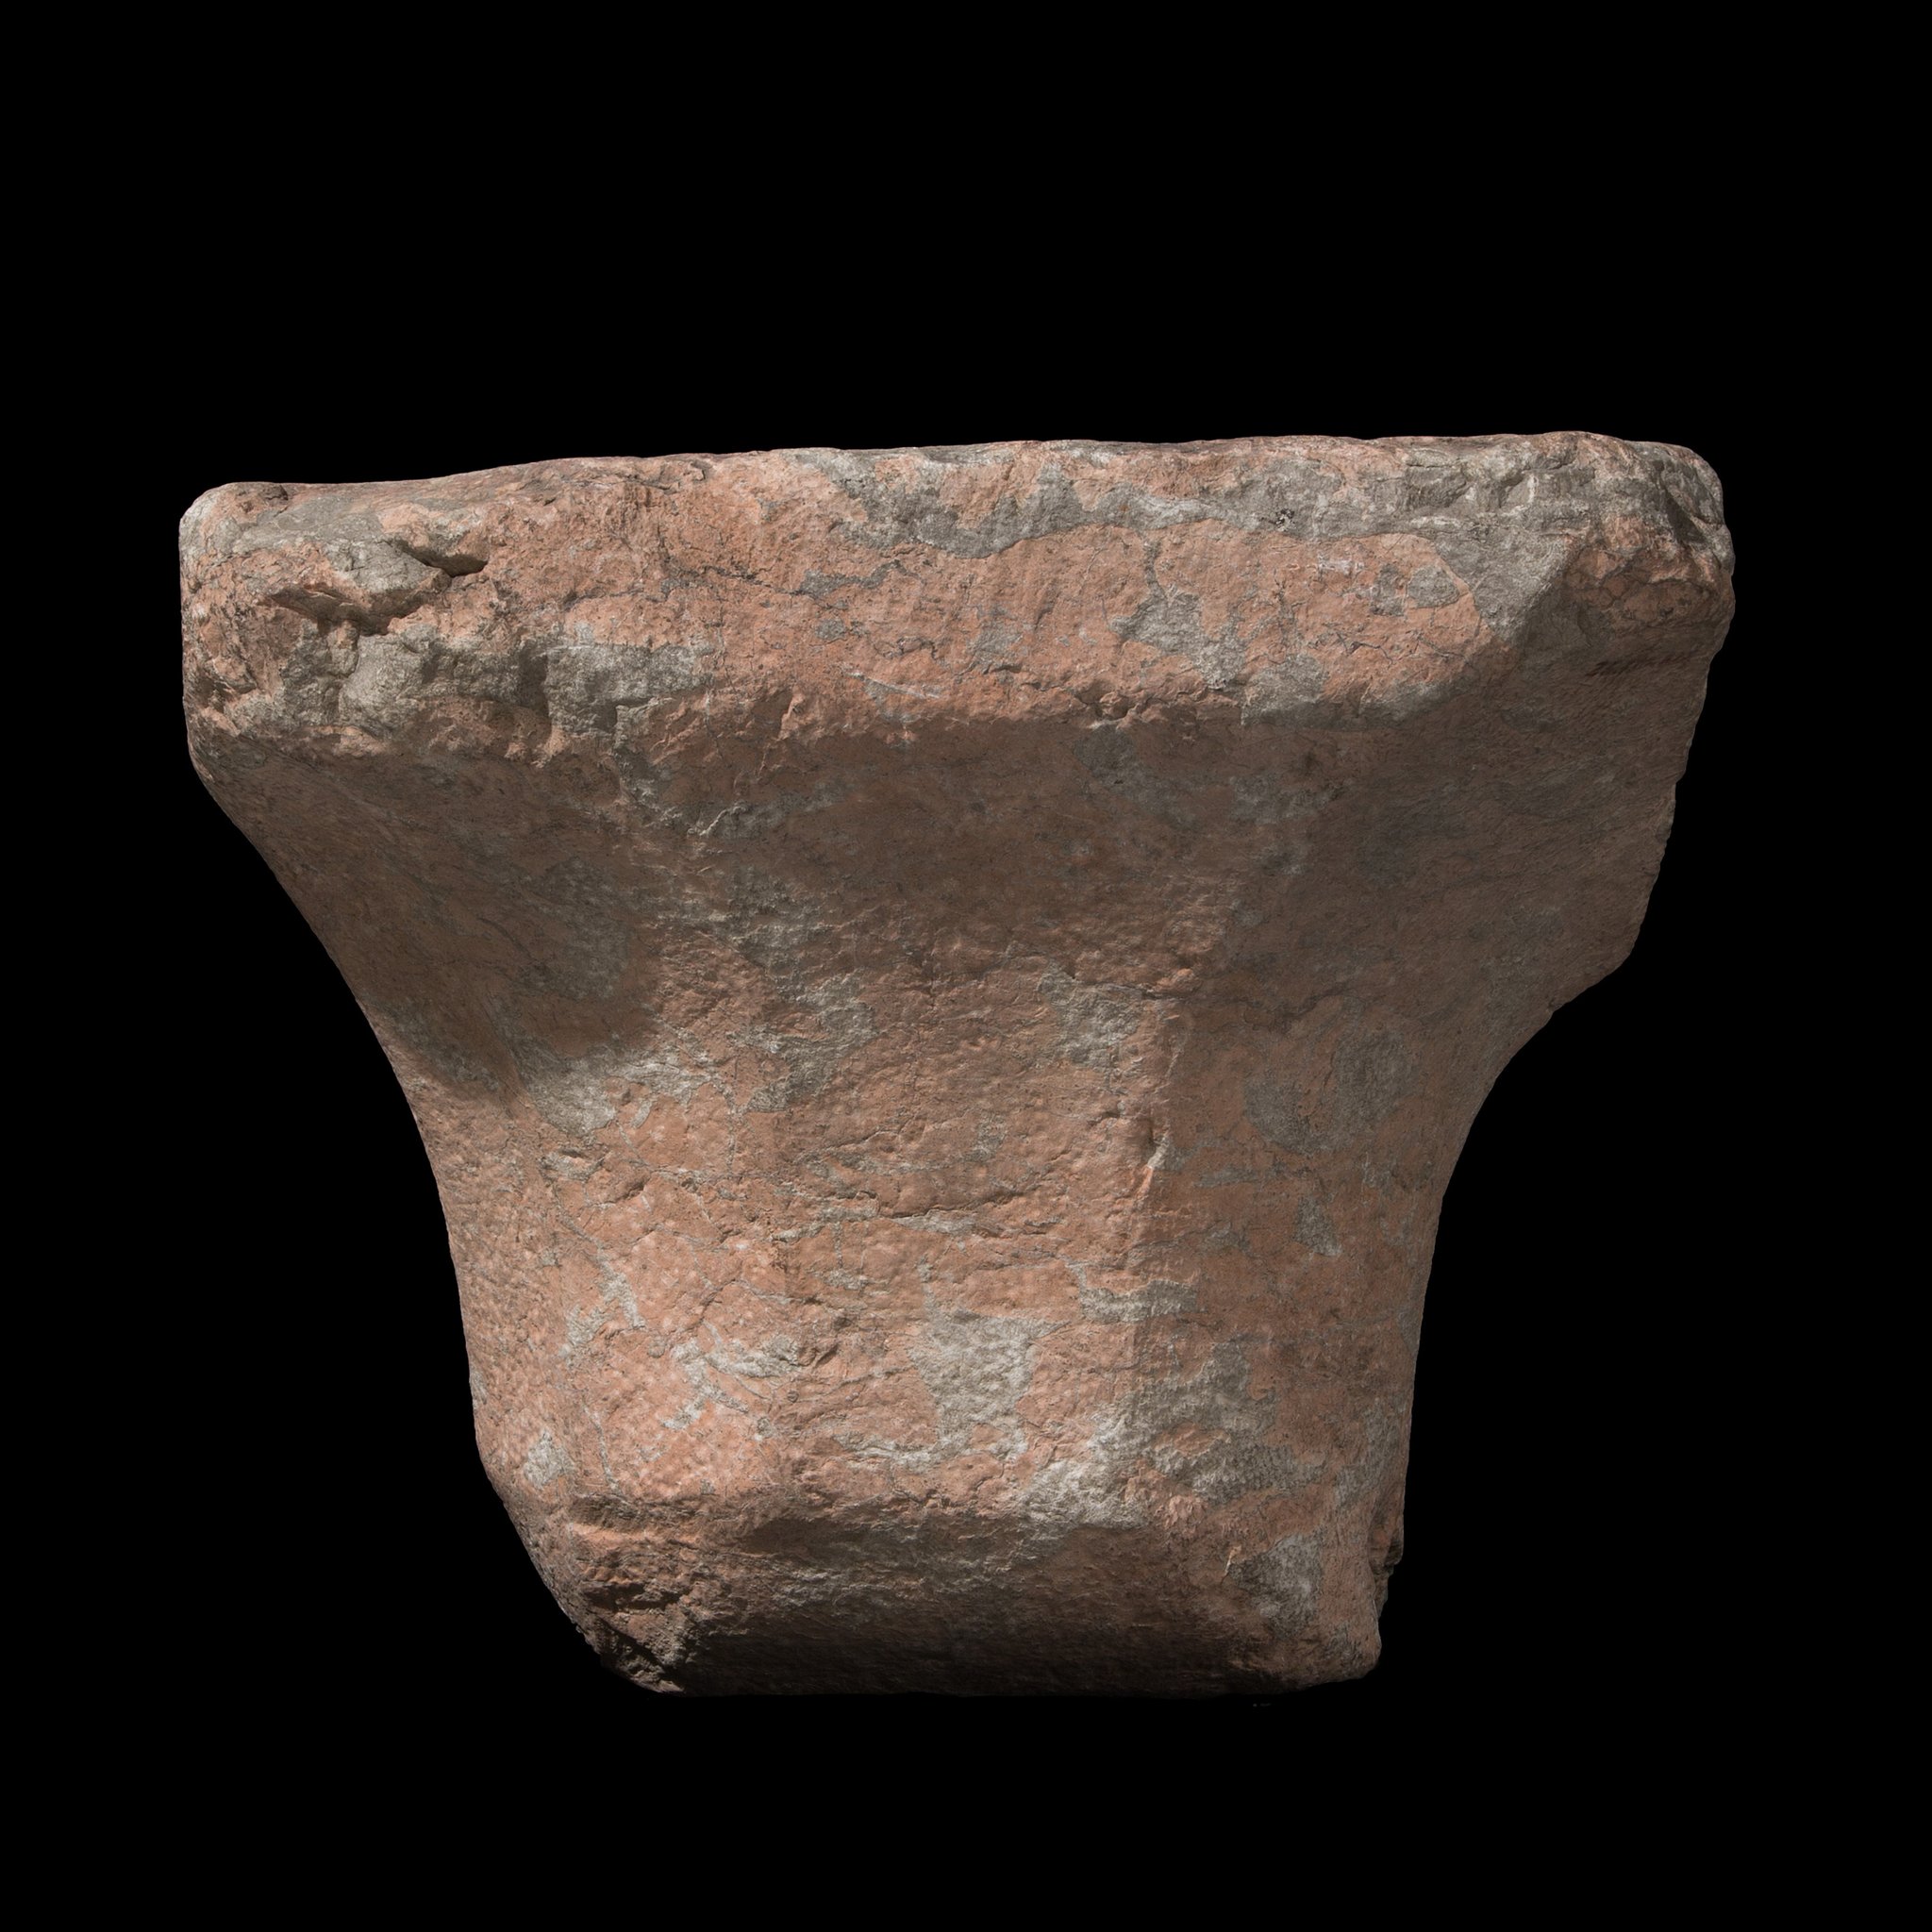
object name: capital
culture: catalan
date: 1130-1140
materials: marble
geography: france